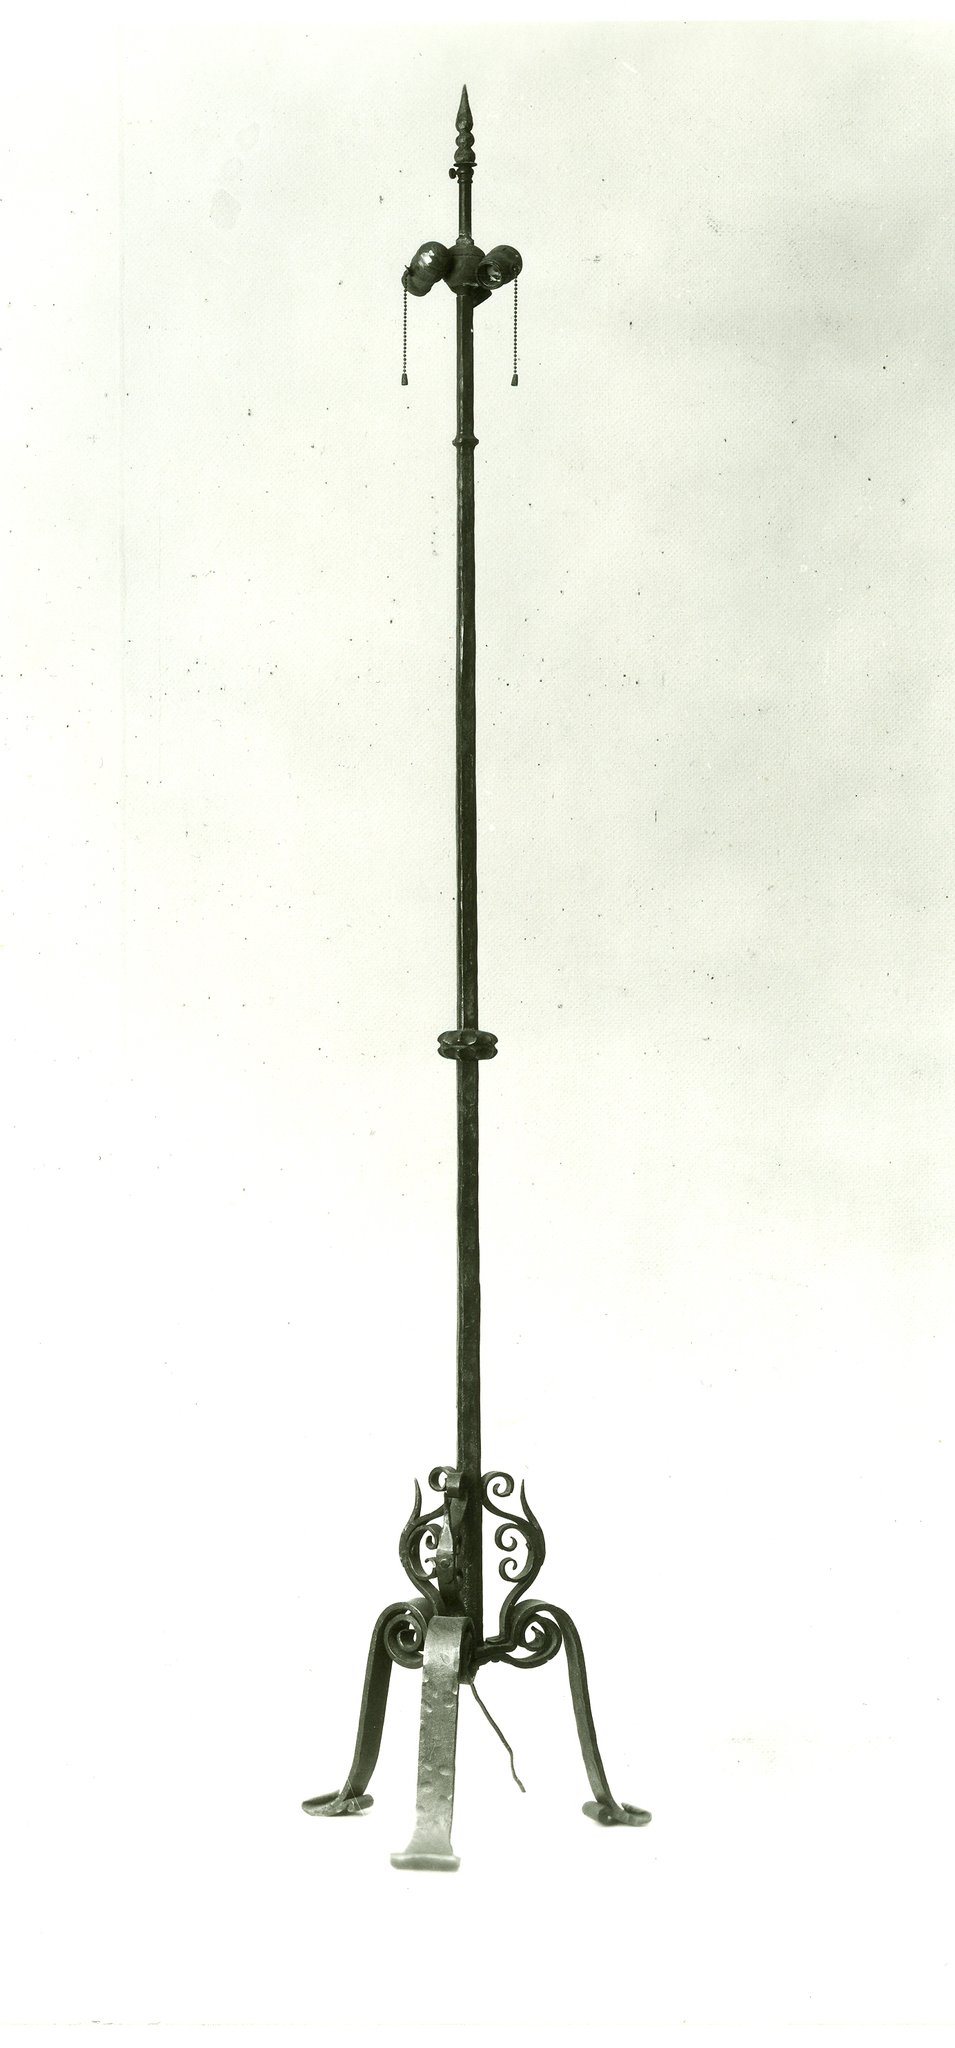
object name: candle pricket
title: Candle pricket (pair with 1975.1.1464)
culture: spanish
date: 1601-1700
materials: iron